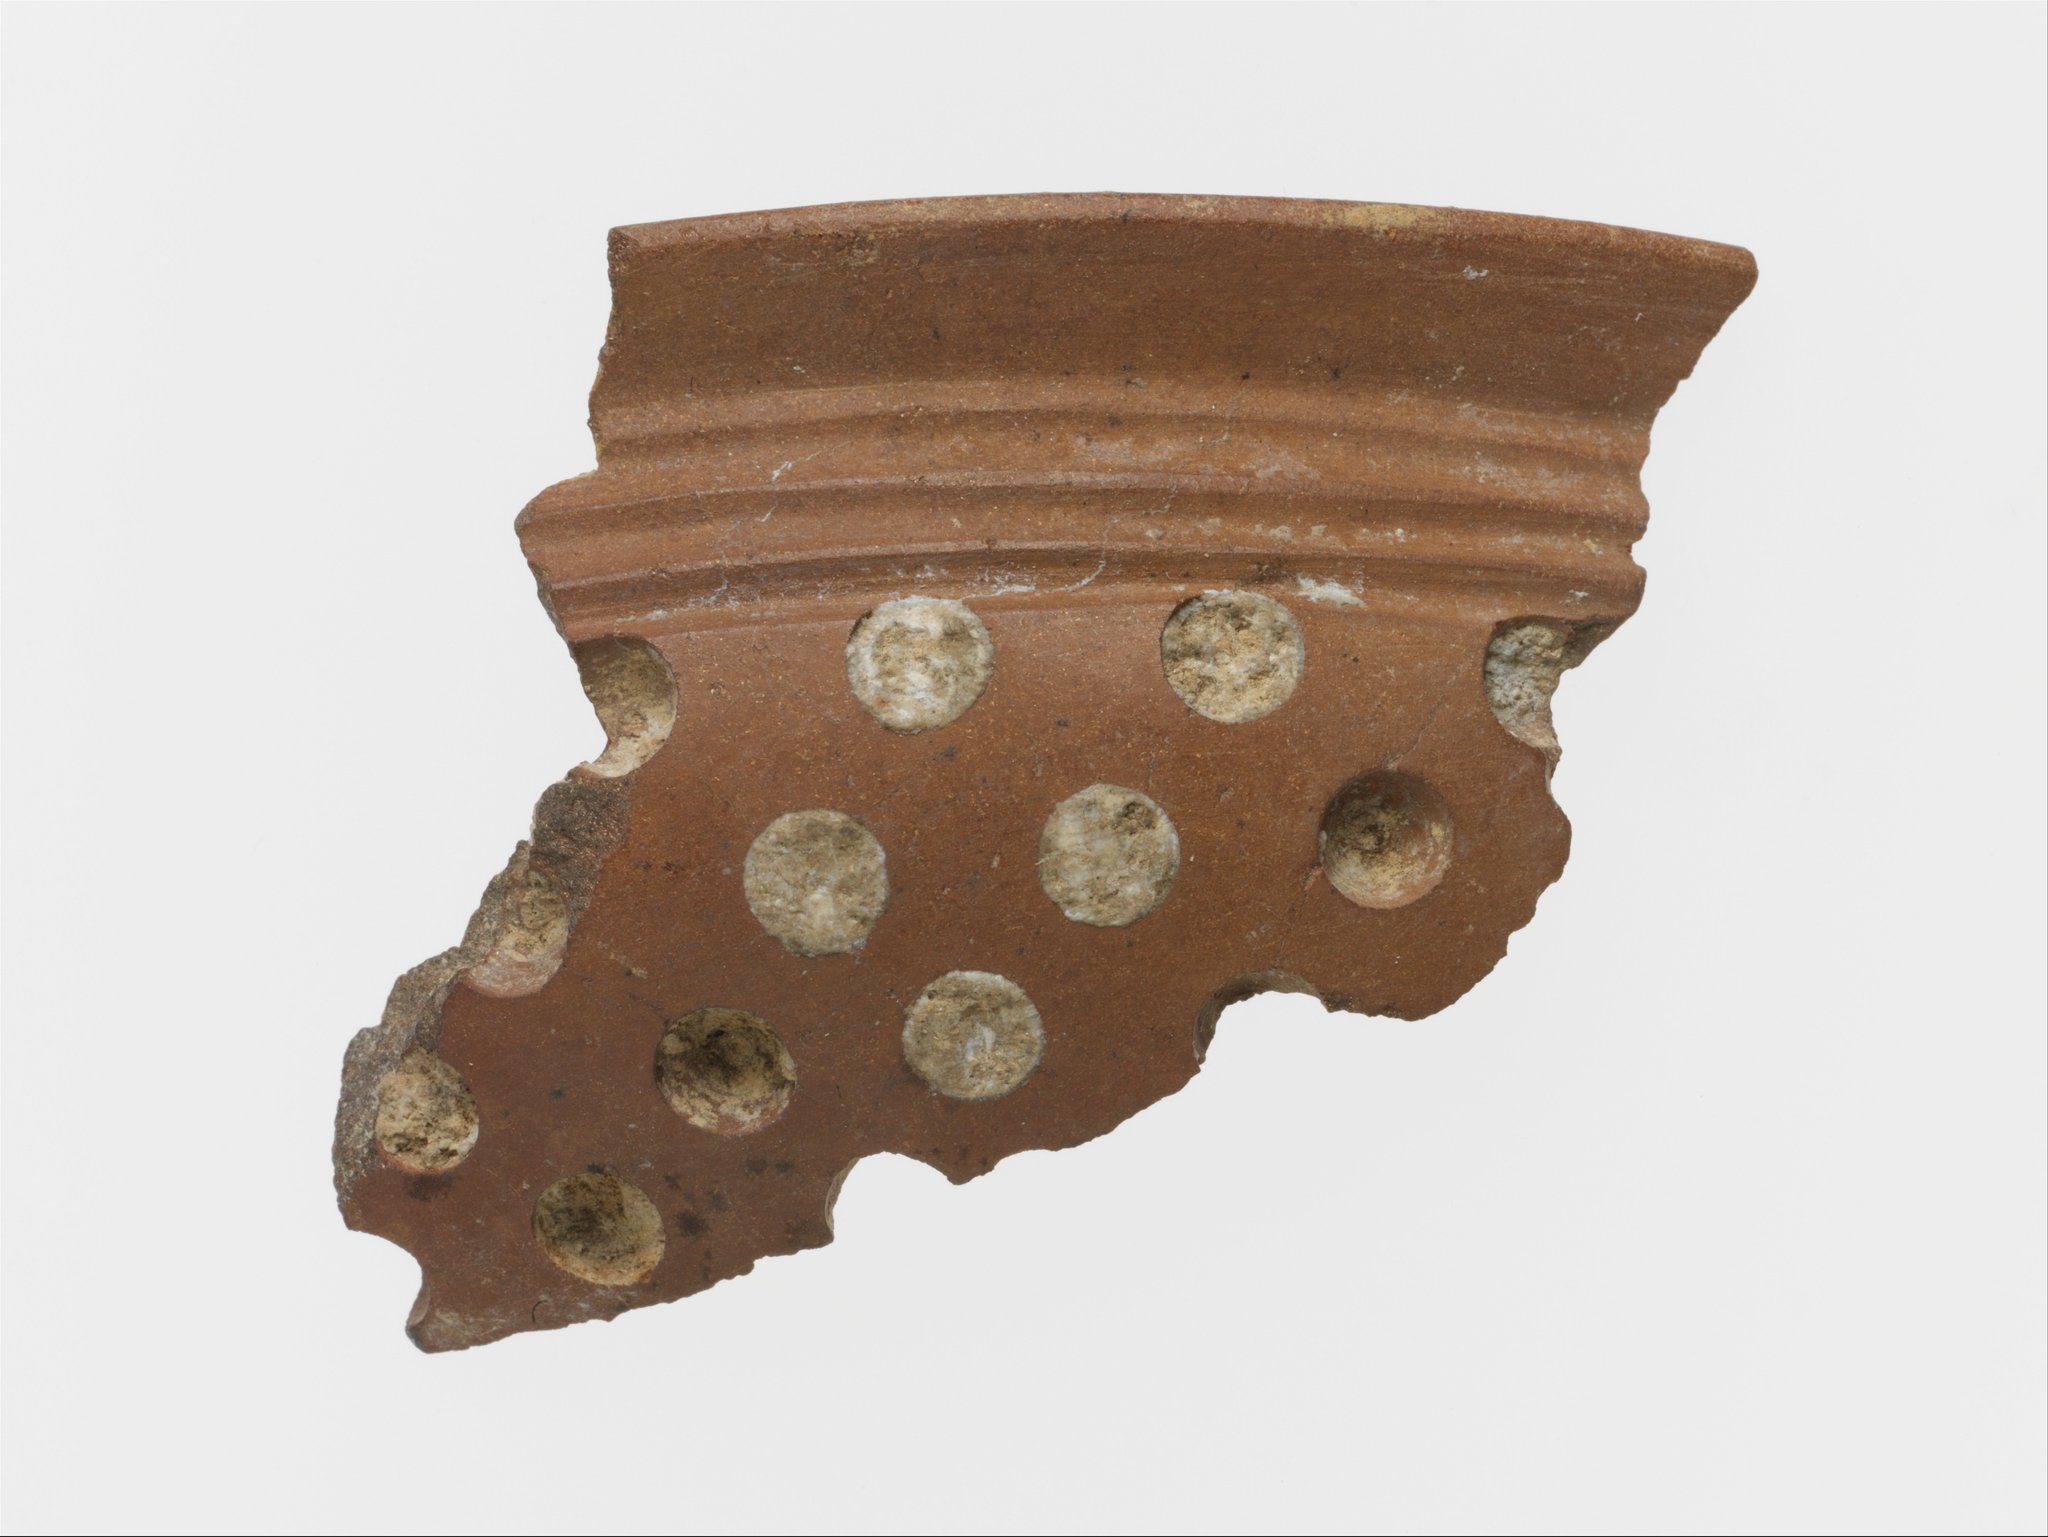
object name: vase fragment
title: Terracotta rim fragment with white inlay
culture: minoan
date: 1800-1700 BCE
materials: terracotta